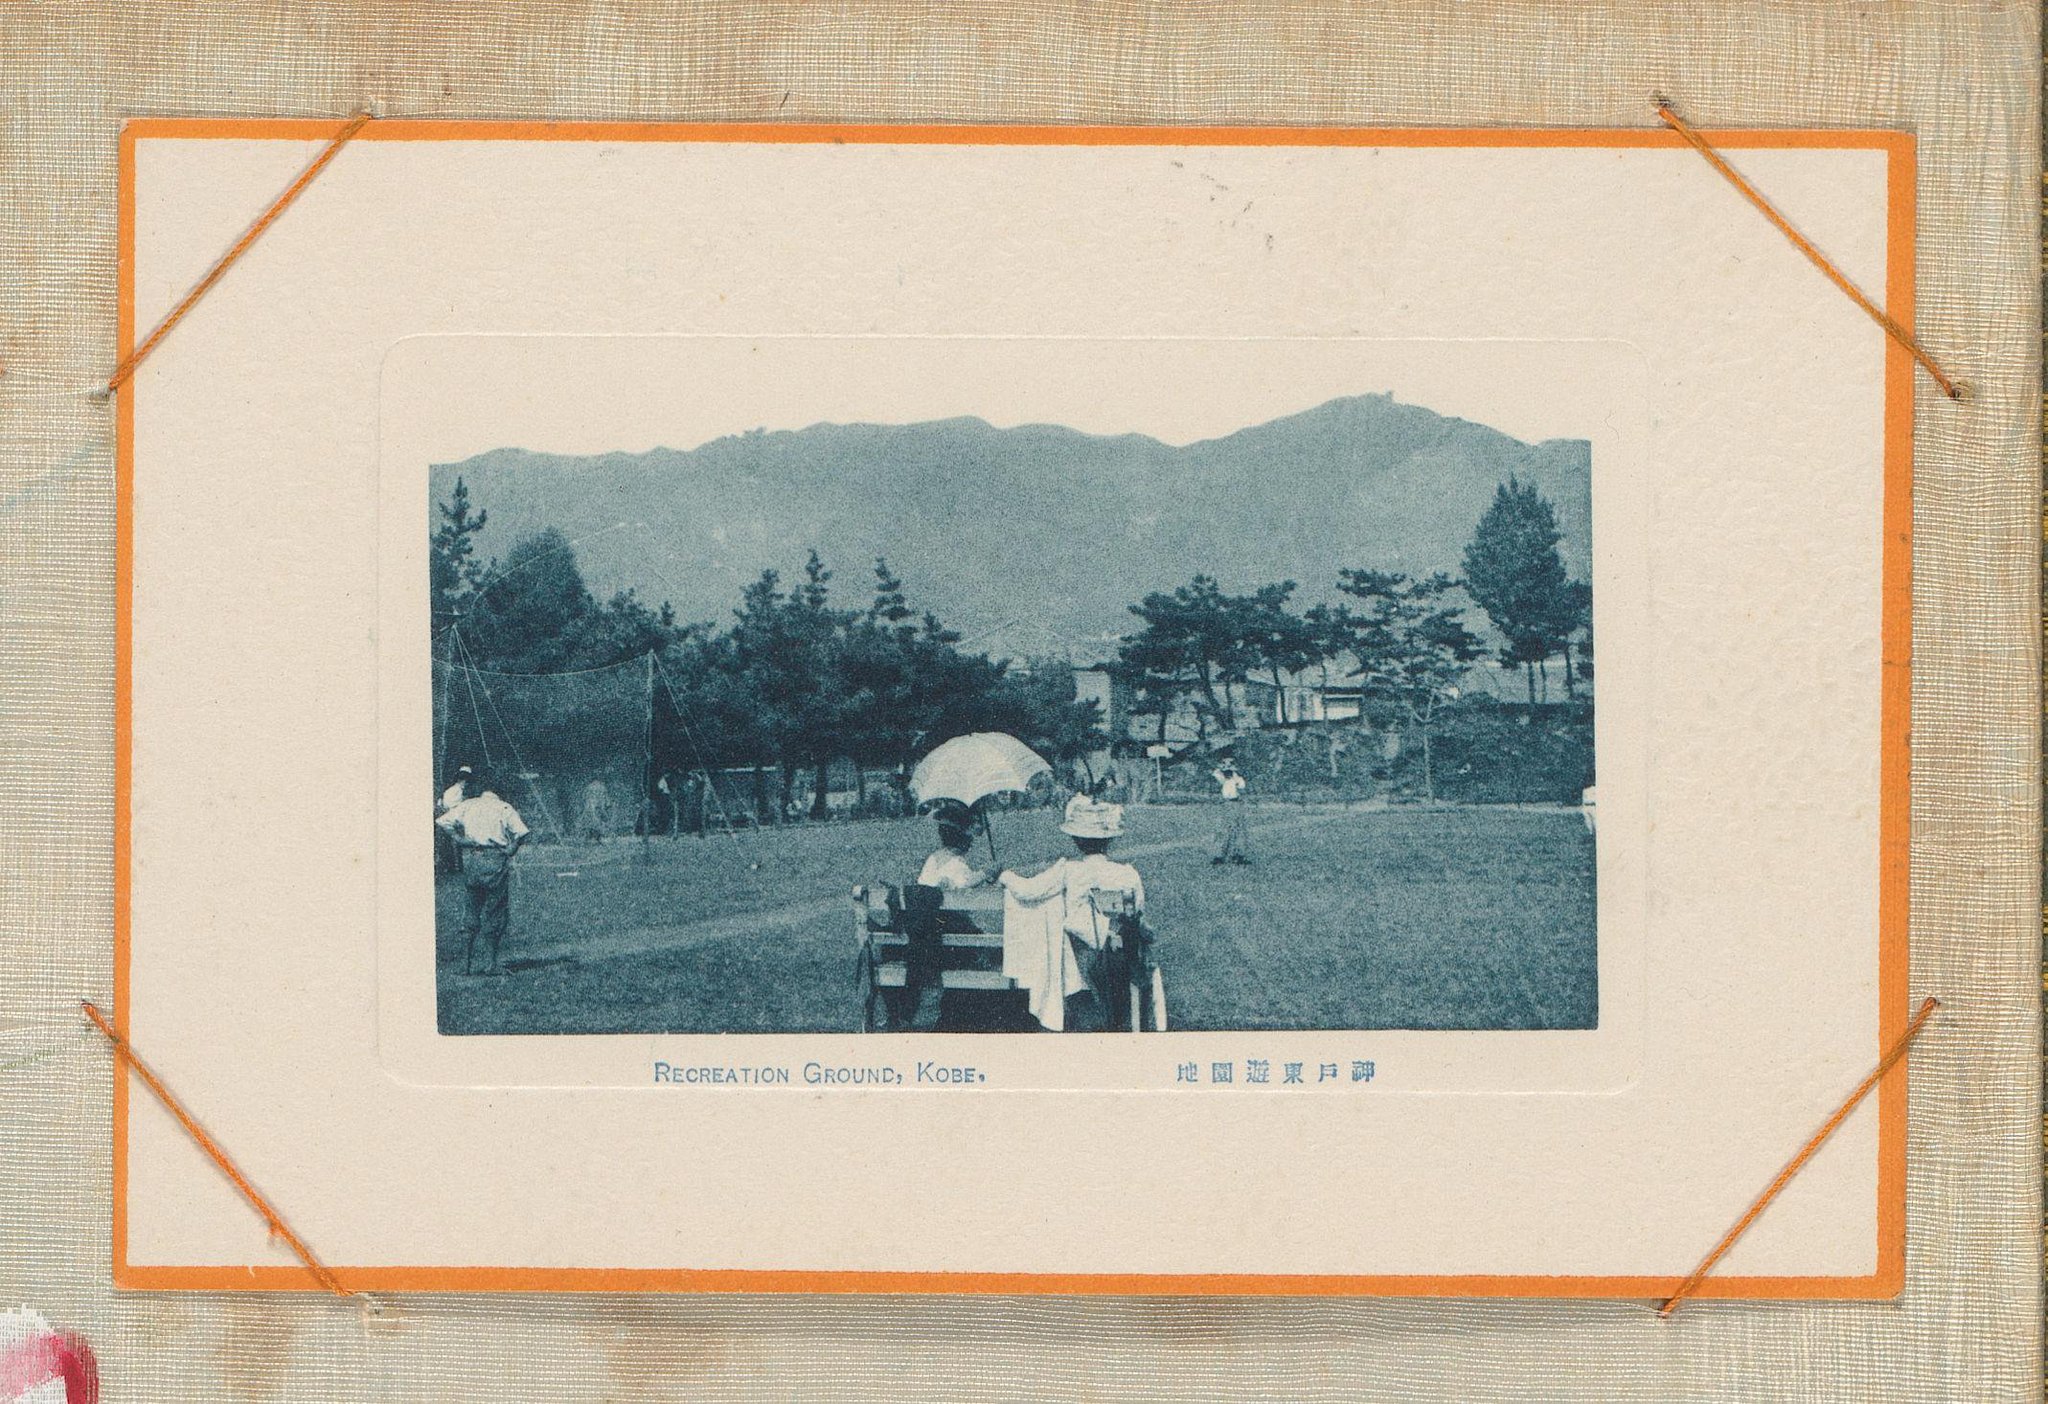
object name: ansichtkaart, prentbriefkaart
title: Gezicht op een recreatiegebied te Kobe, Japan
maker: Anonymous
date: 1900-1920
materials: paper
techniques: photograph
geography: kobe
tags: open-air recreation, parasol, sunshade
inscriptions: title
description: Deze prent maakt deel uit van een album.